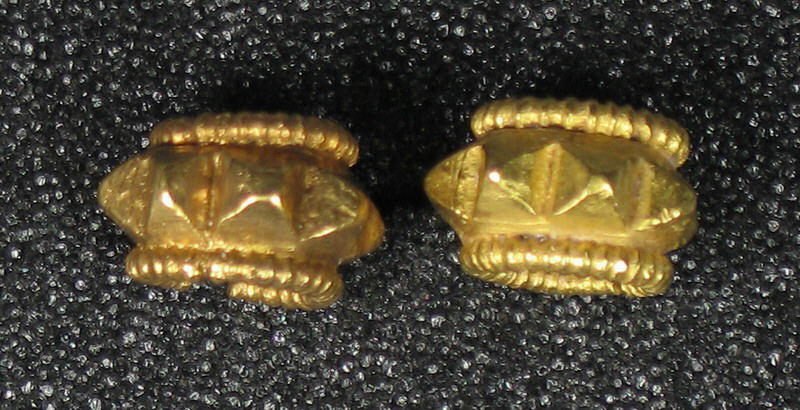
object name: pair of ear ornament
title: Pair of Ear Ornaments, Pyramid Type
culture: indonesian, central java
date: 701-1200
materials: gold